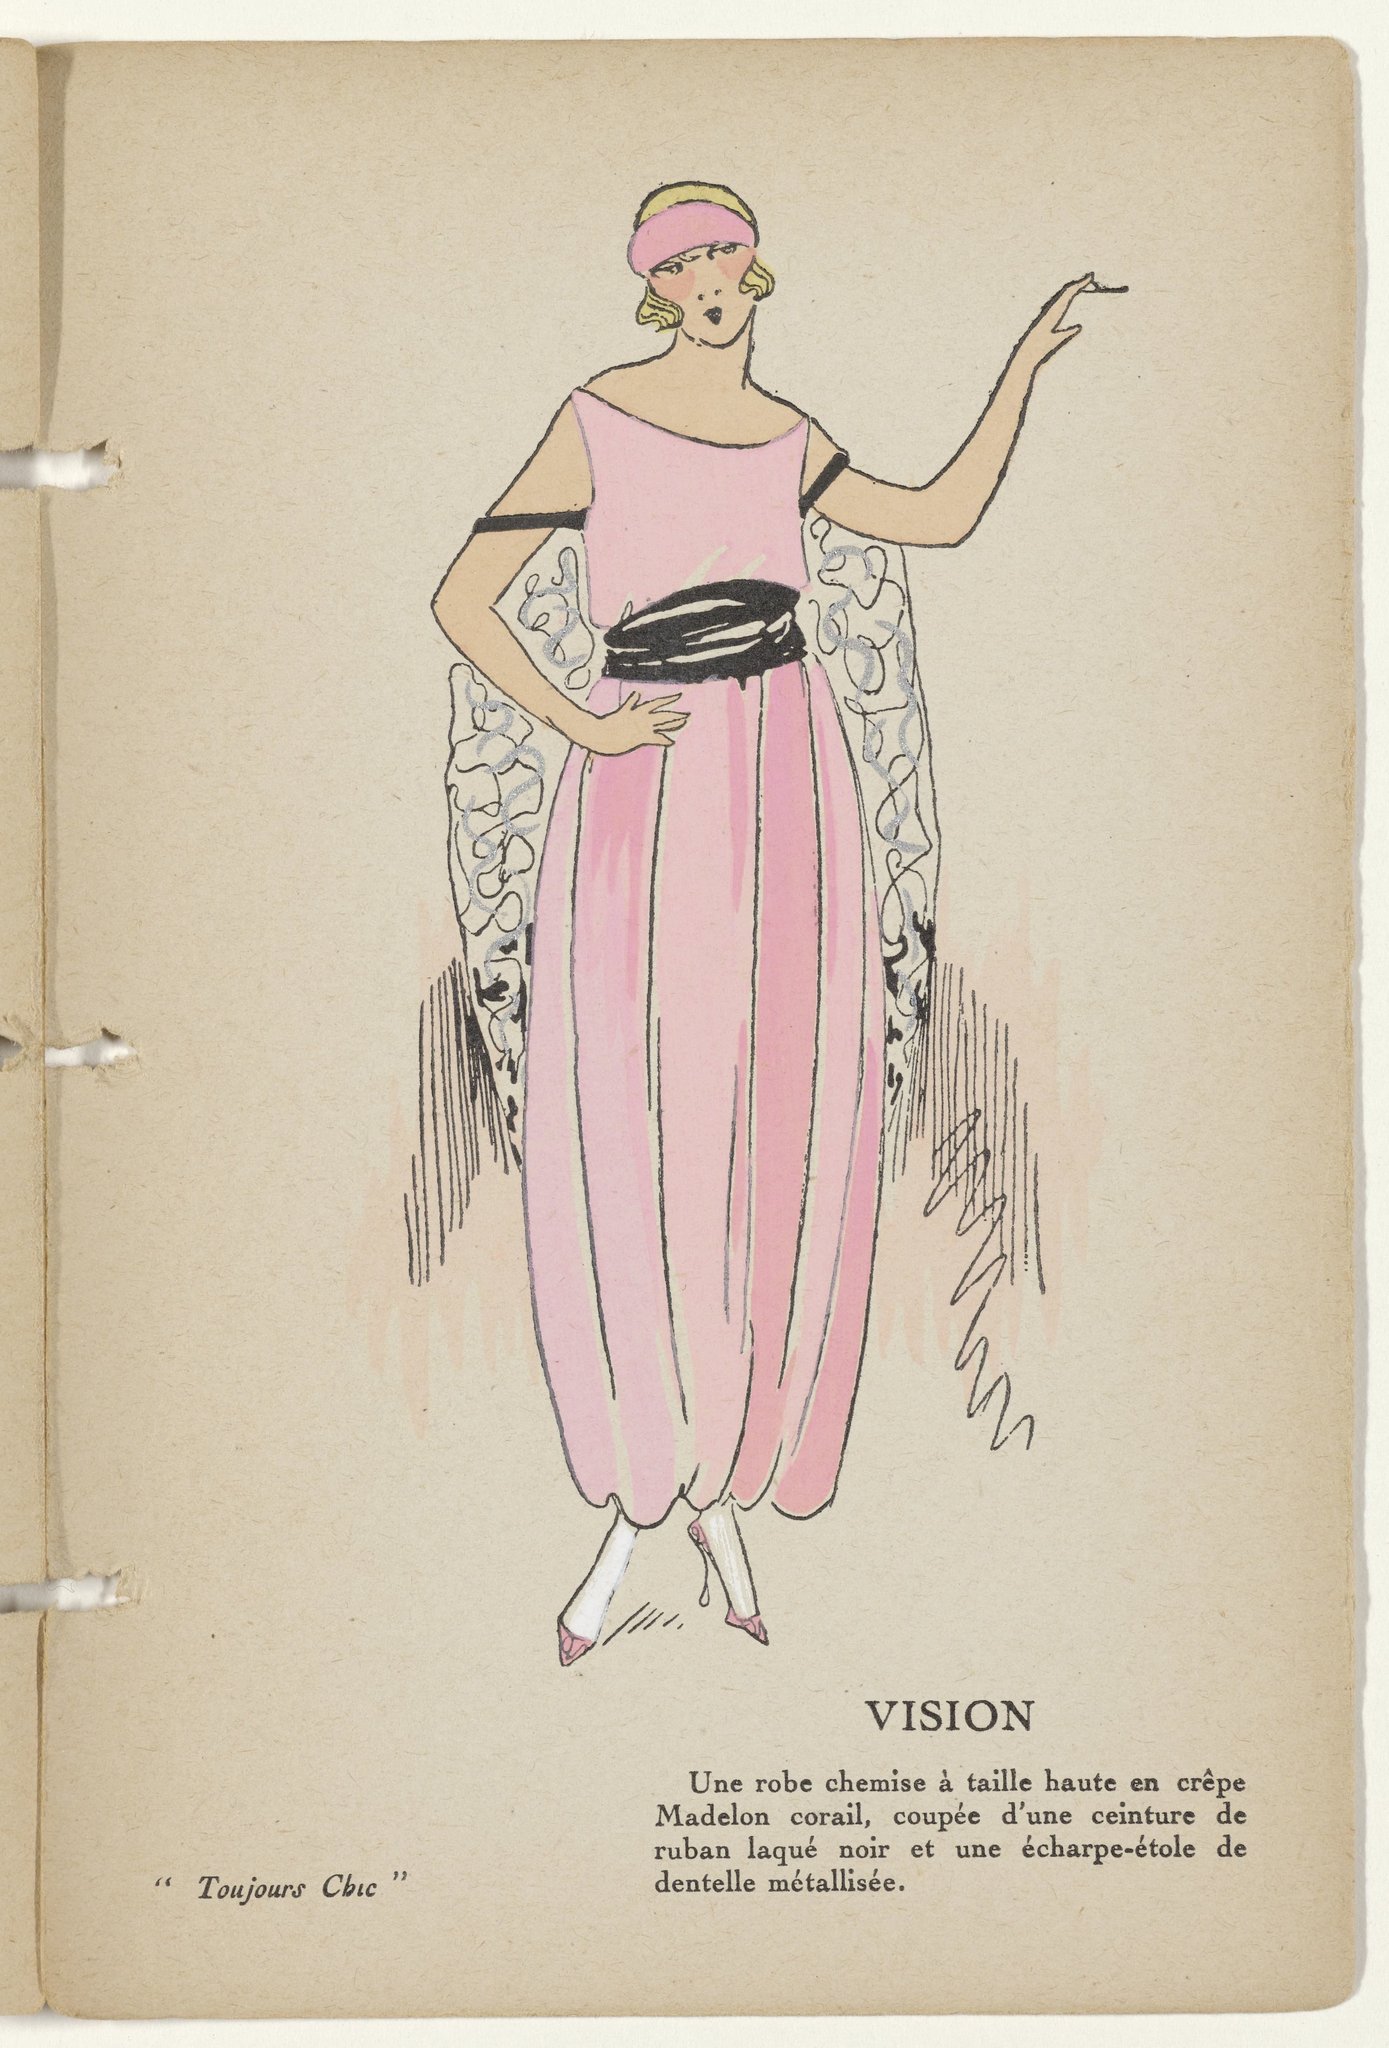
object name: fashion print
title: Toujours Chic Les Deshabillés, Hiver 1921-1922: Vision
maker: g-p. joumard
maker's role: publisher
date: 1921-1922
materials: paper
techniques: letterpress printing, pochoir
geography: paris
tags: fashion plates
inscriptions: date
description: Prent uit Catalogus "Toujours Chic" waarin een overzicht van de wintermode 1921-1922.